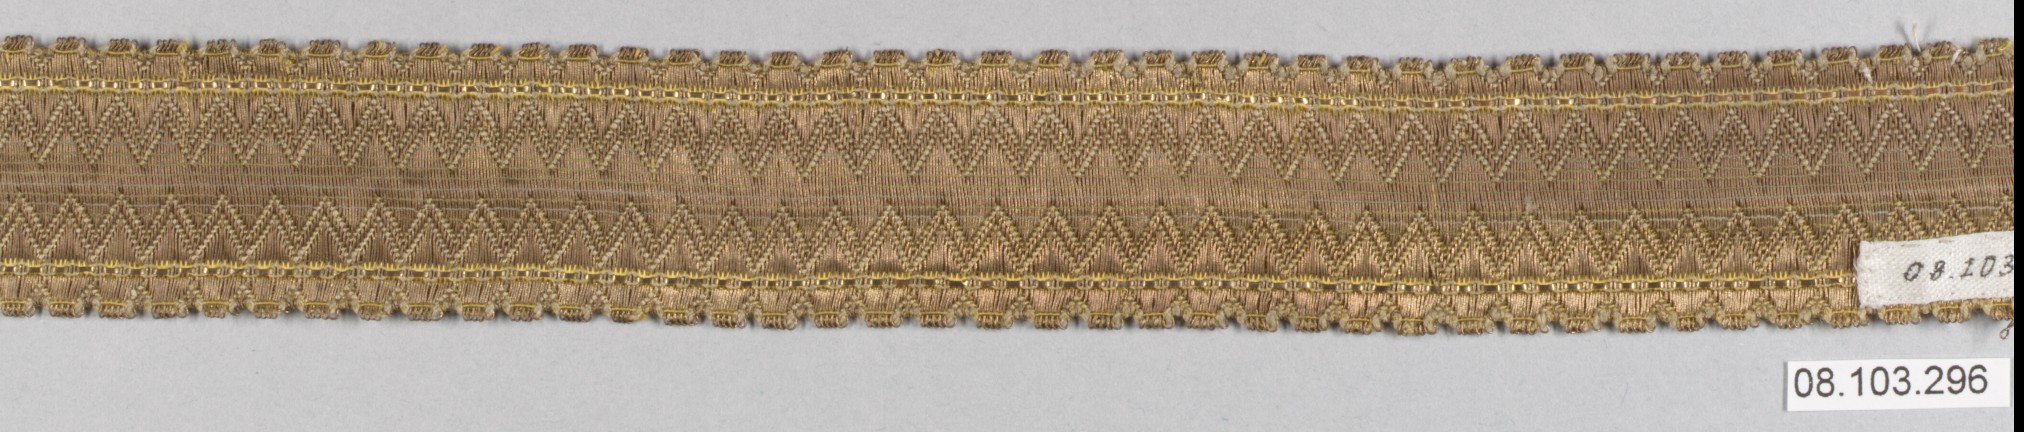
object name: galloon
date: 1601-1800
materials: metal thread